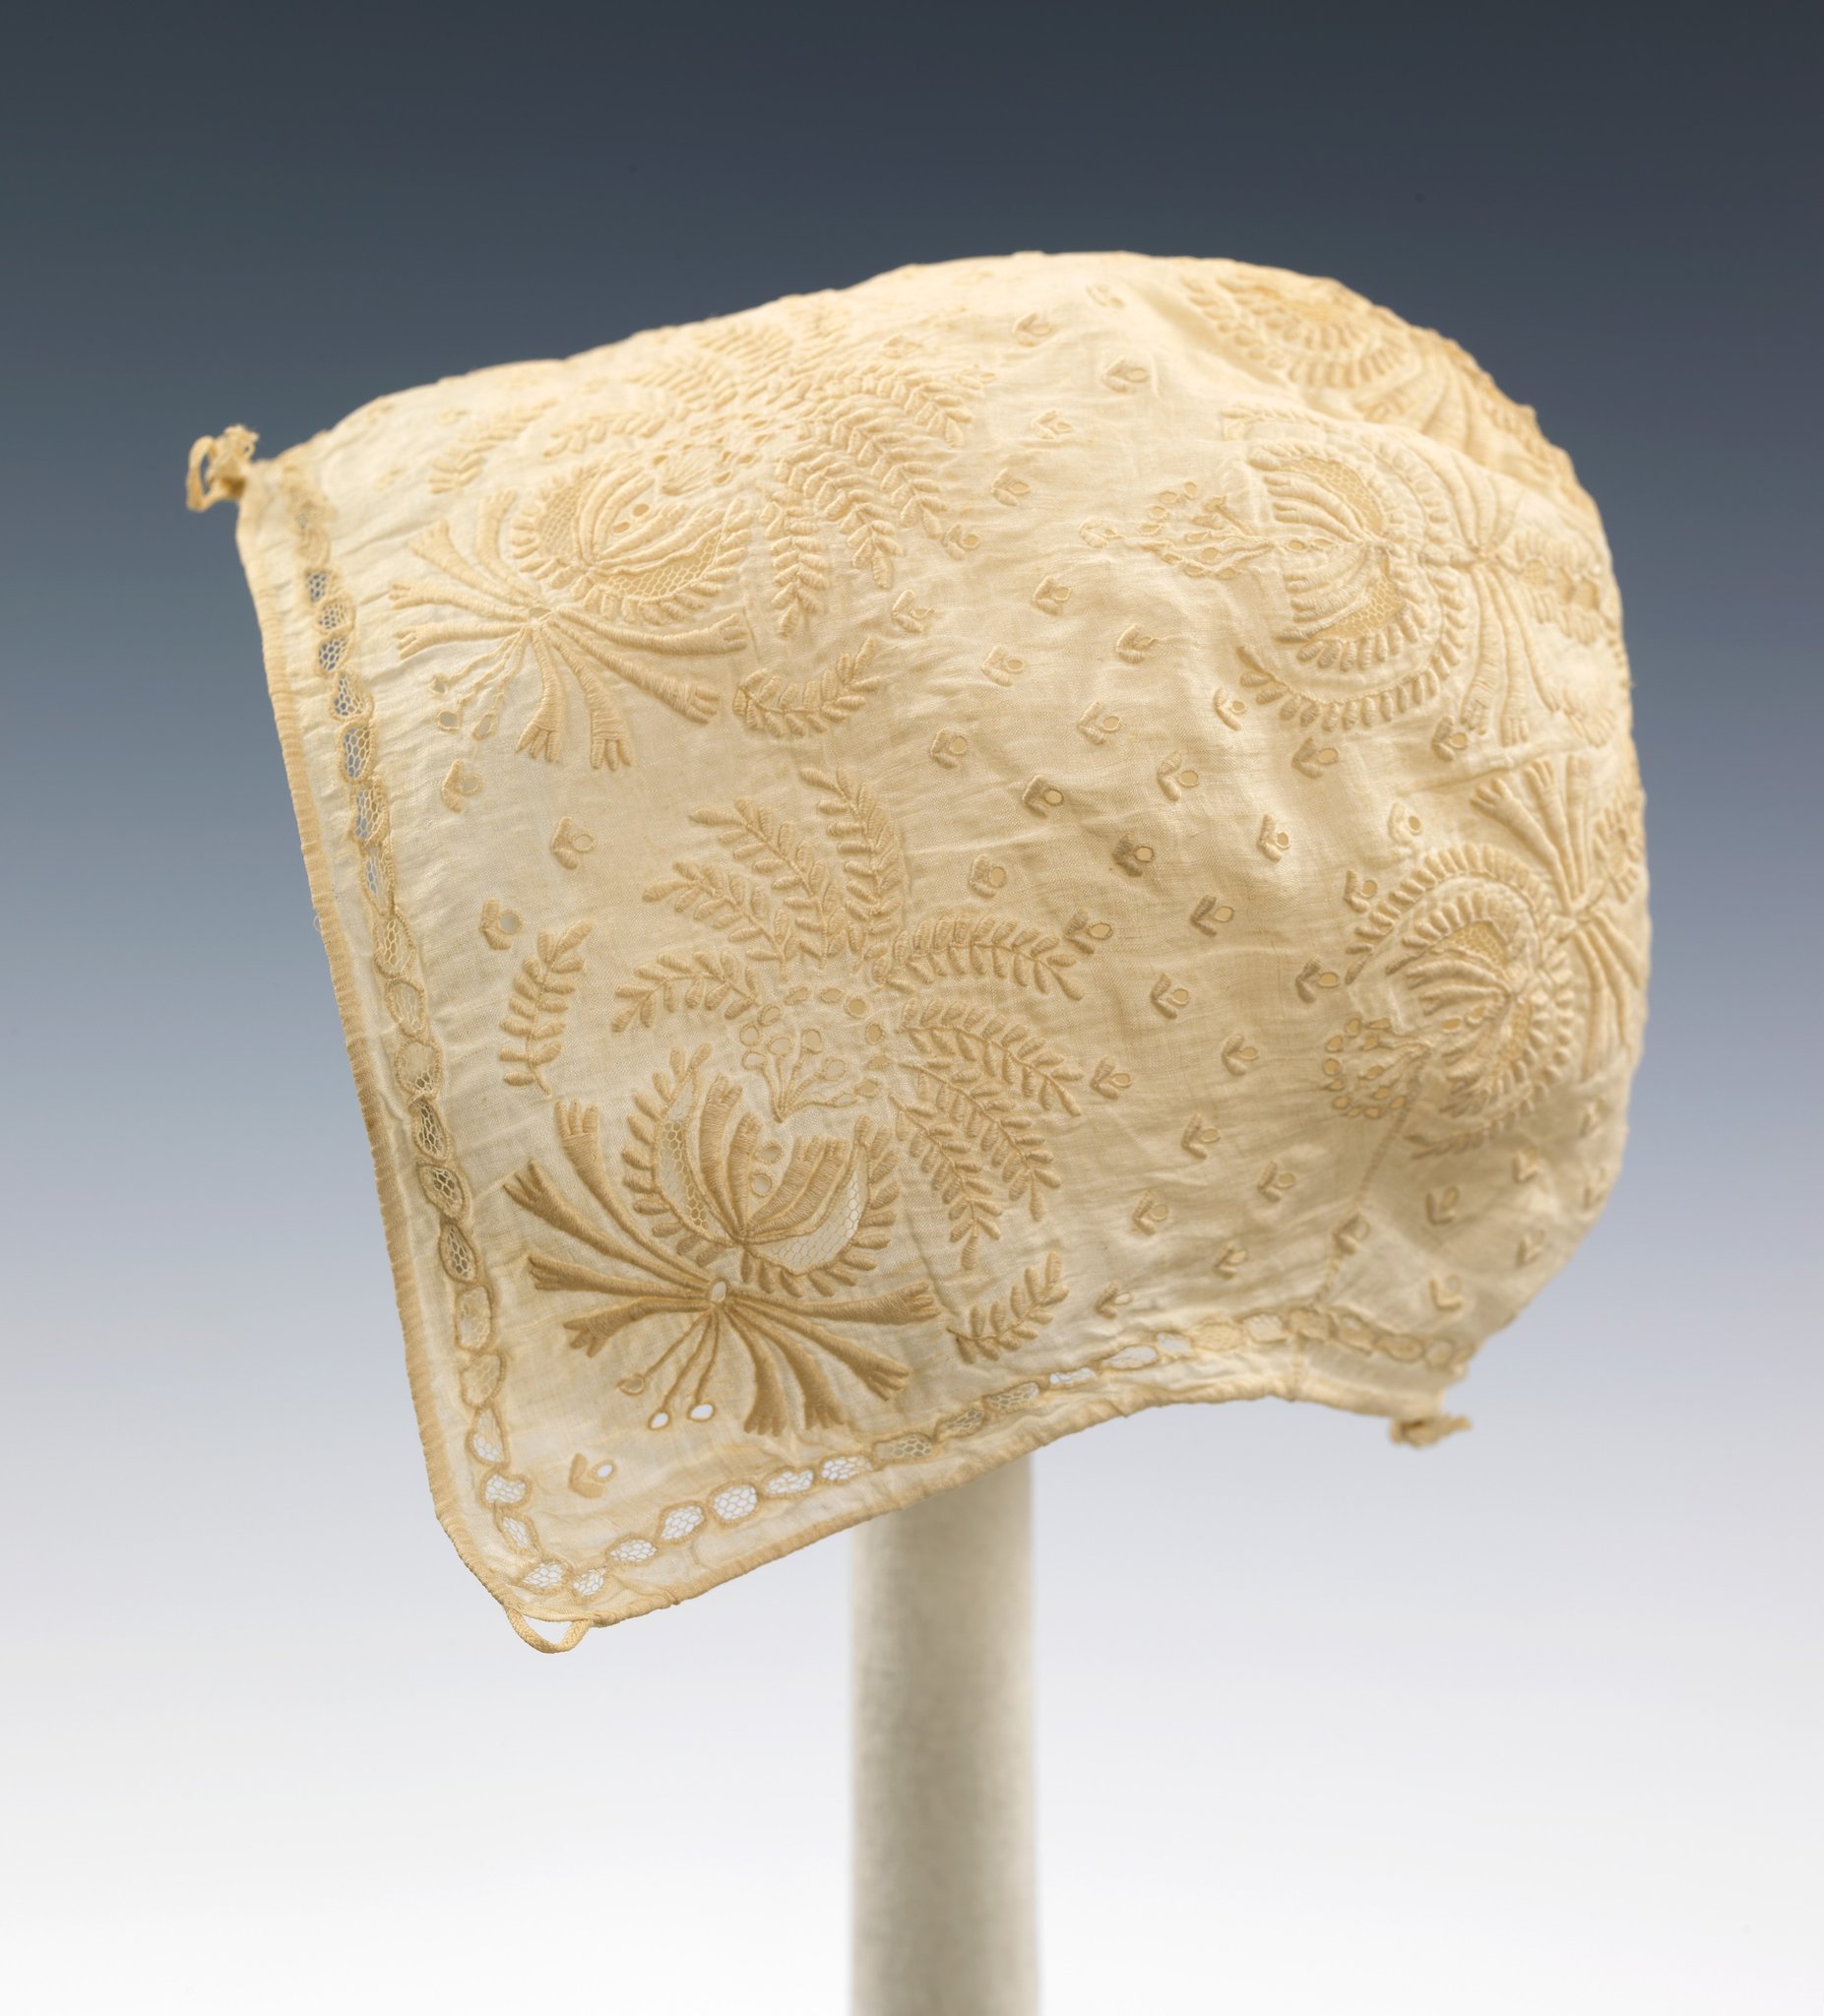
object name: cap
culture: american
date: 1813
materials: cotton